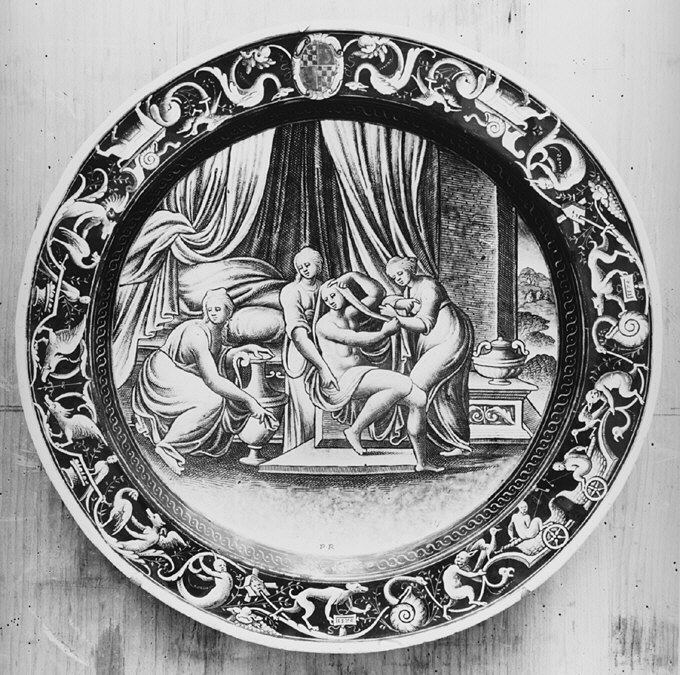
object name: plate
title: The Toilet of Psyche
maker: pierre reymond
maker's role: enameler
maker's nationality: french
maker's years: 1513-1590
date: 1570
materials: copper, enamel, gilt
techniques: painting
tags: women,beds